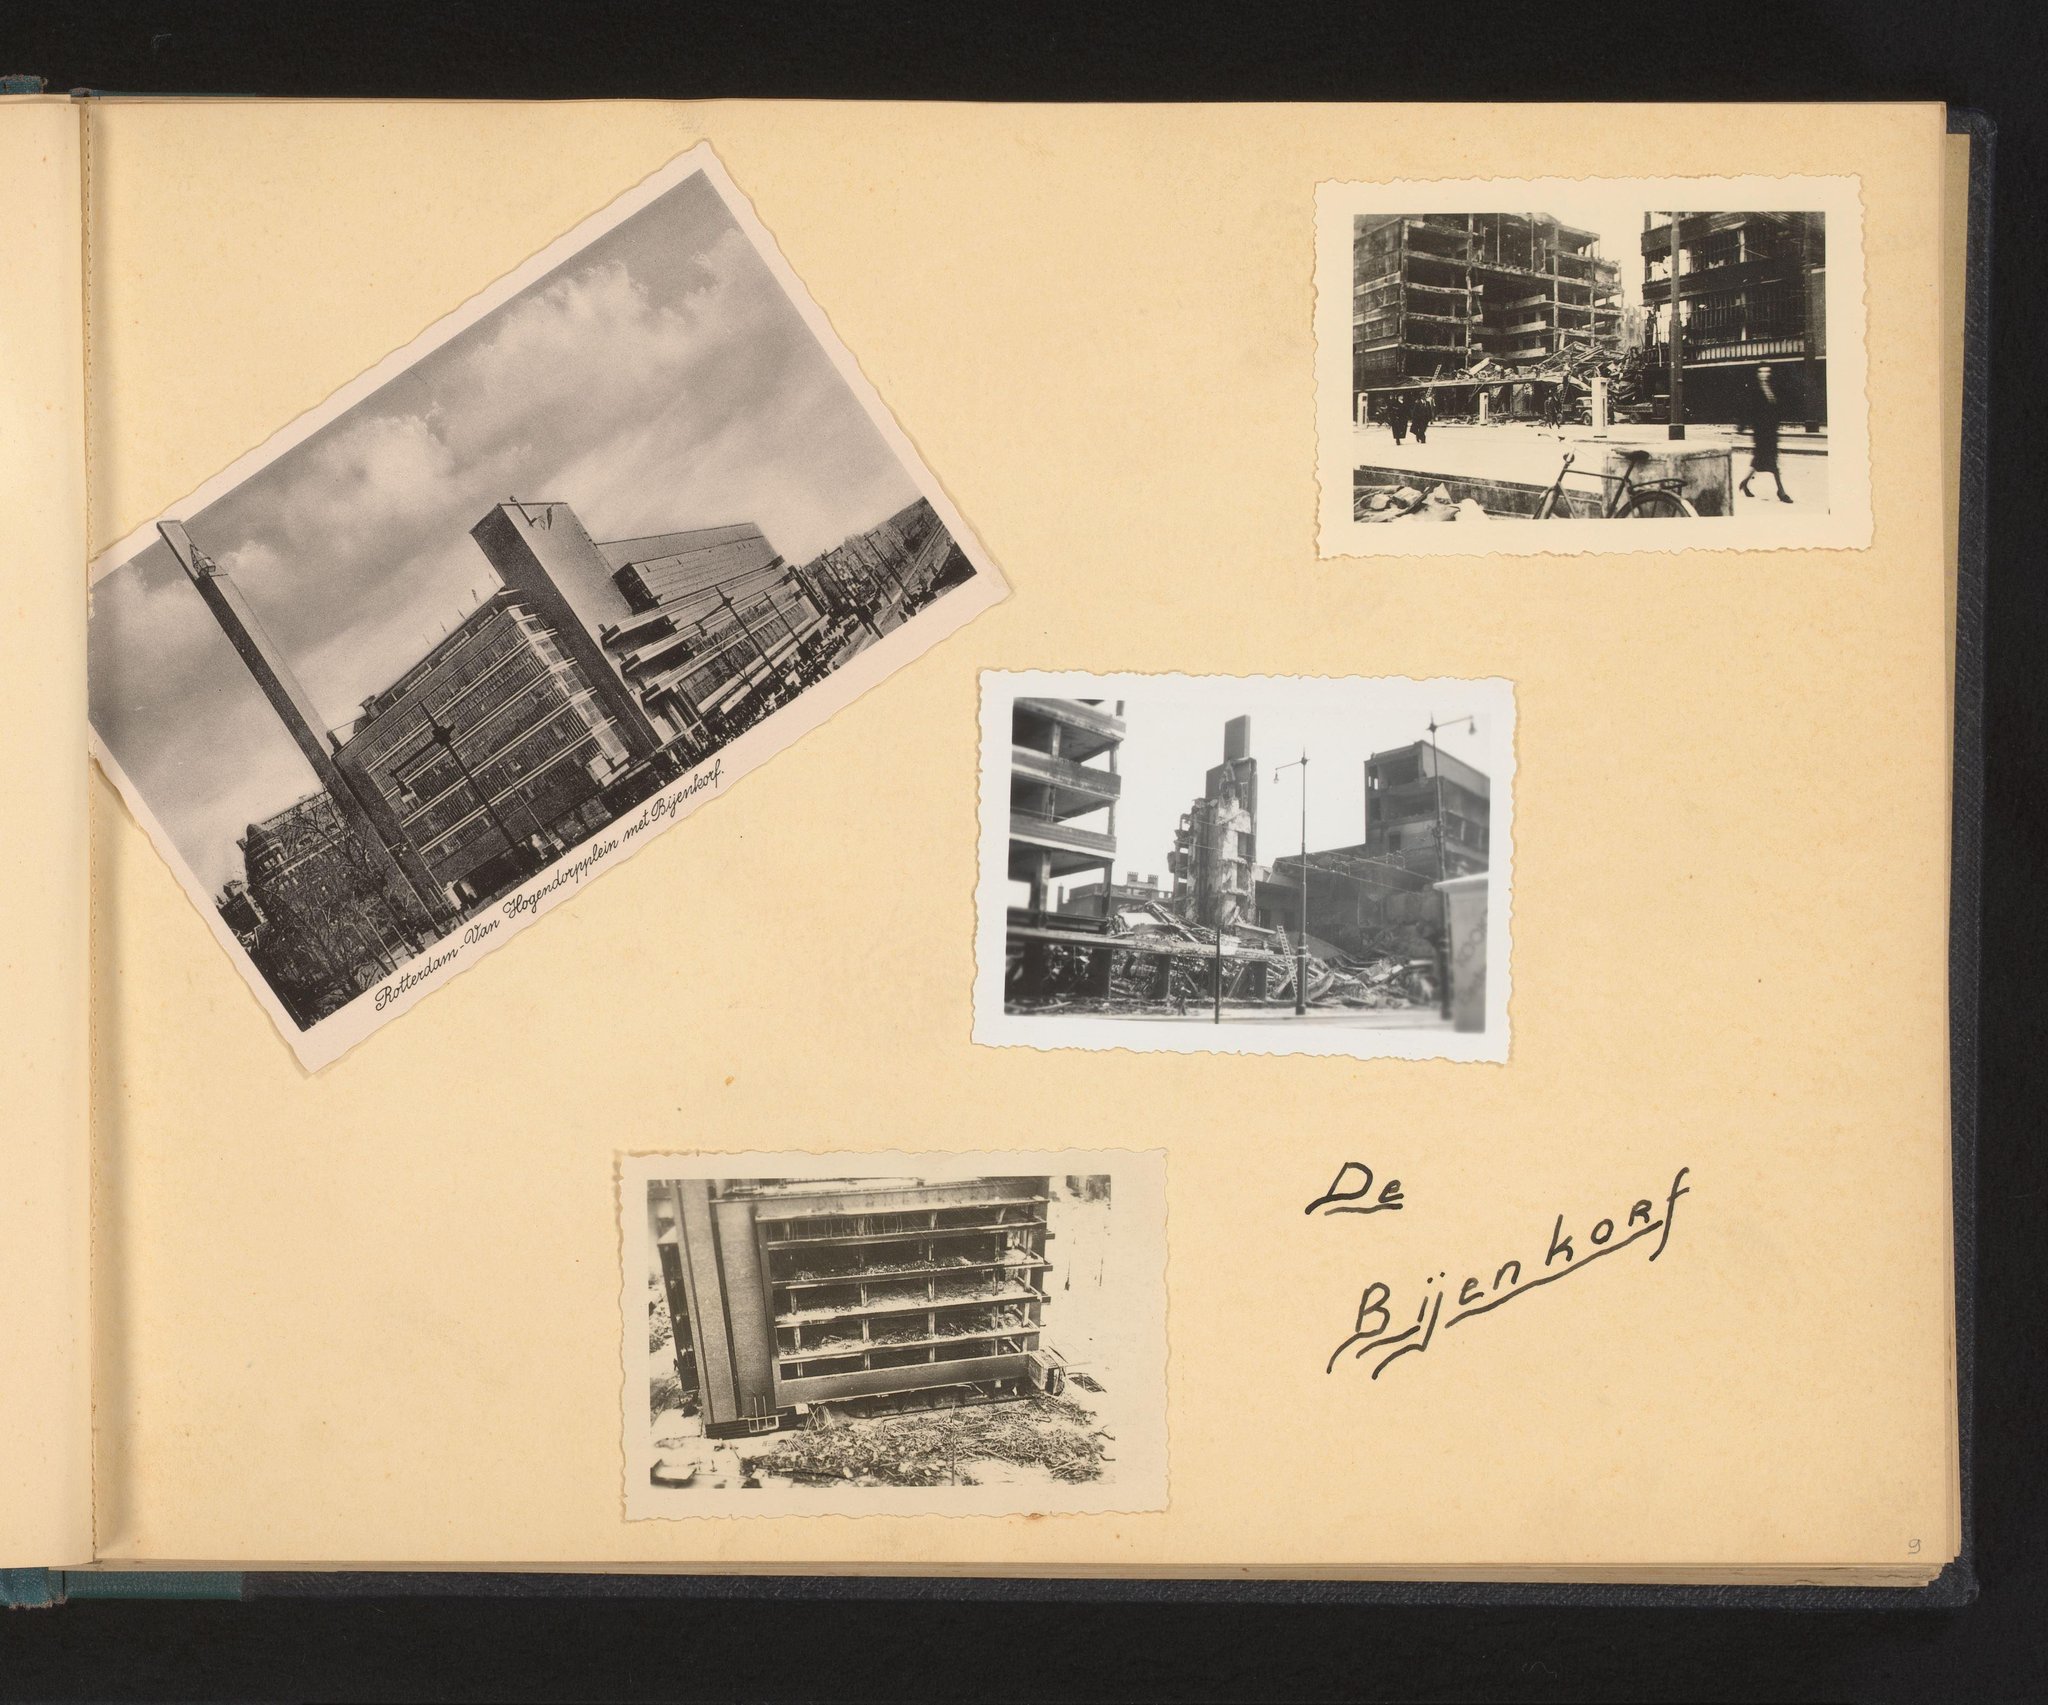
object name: album leaf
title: De Bijenkorf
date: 1940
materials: cardboard, paper, photographic support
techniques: photograph, gelatin silver print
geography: rotterdam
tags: store, non-combatants ~ war, department store, supermarket, devastated, ruined place or city (~ warfare), rotterdam, rotterdam blitz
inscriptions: inscription: ‘De Bijenkorf’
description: Albumblad met drie foto's en een briefkaart. Briefkaart van de Bijenkorf vóór de oorlog en de drie foto's van het warenhuis na het bombardement. Onderdeel van het fotoalbum over de verwoestingen van Nederlandse steden en infrastructuur in het begin van de Tweede Wereldoorlog.